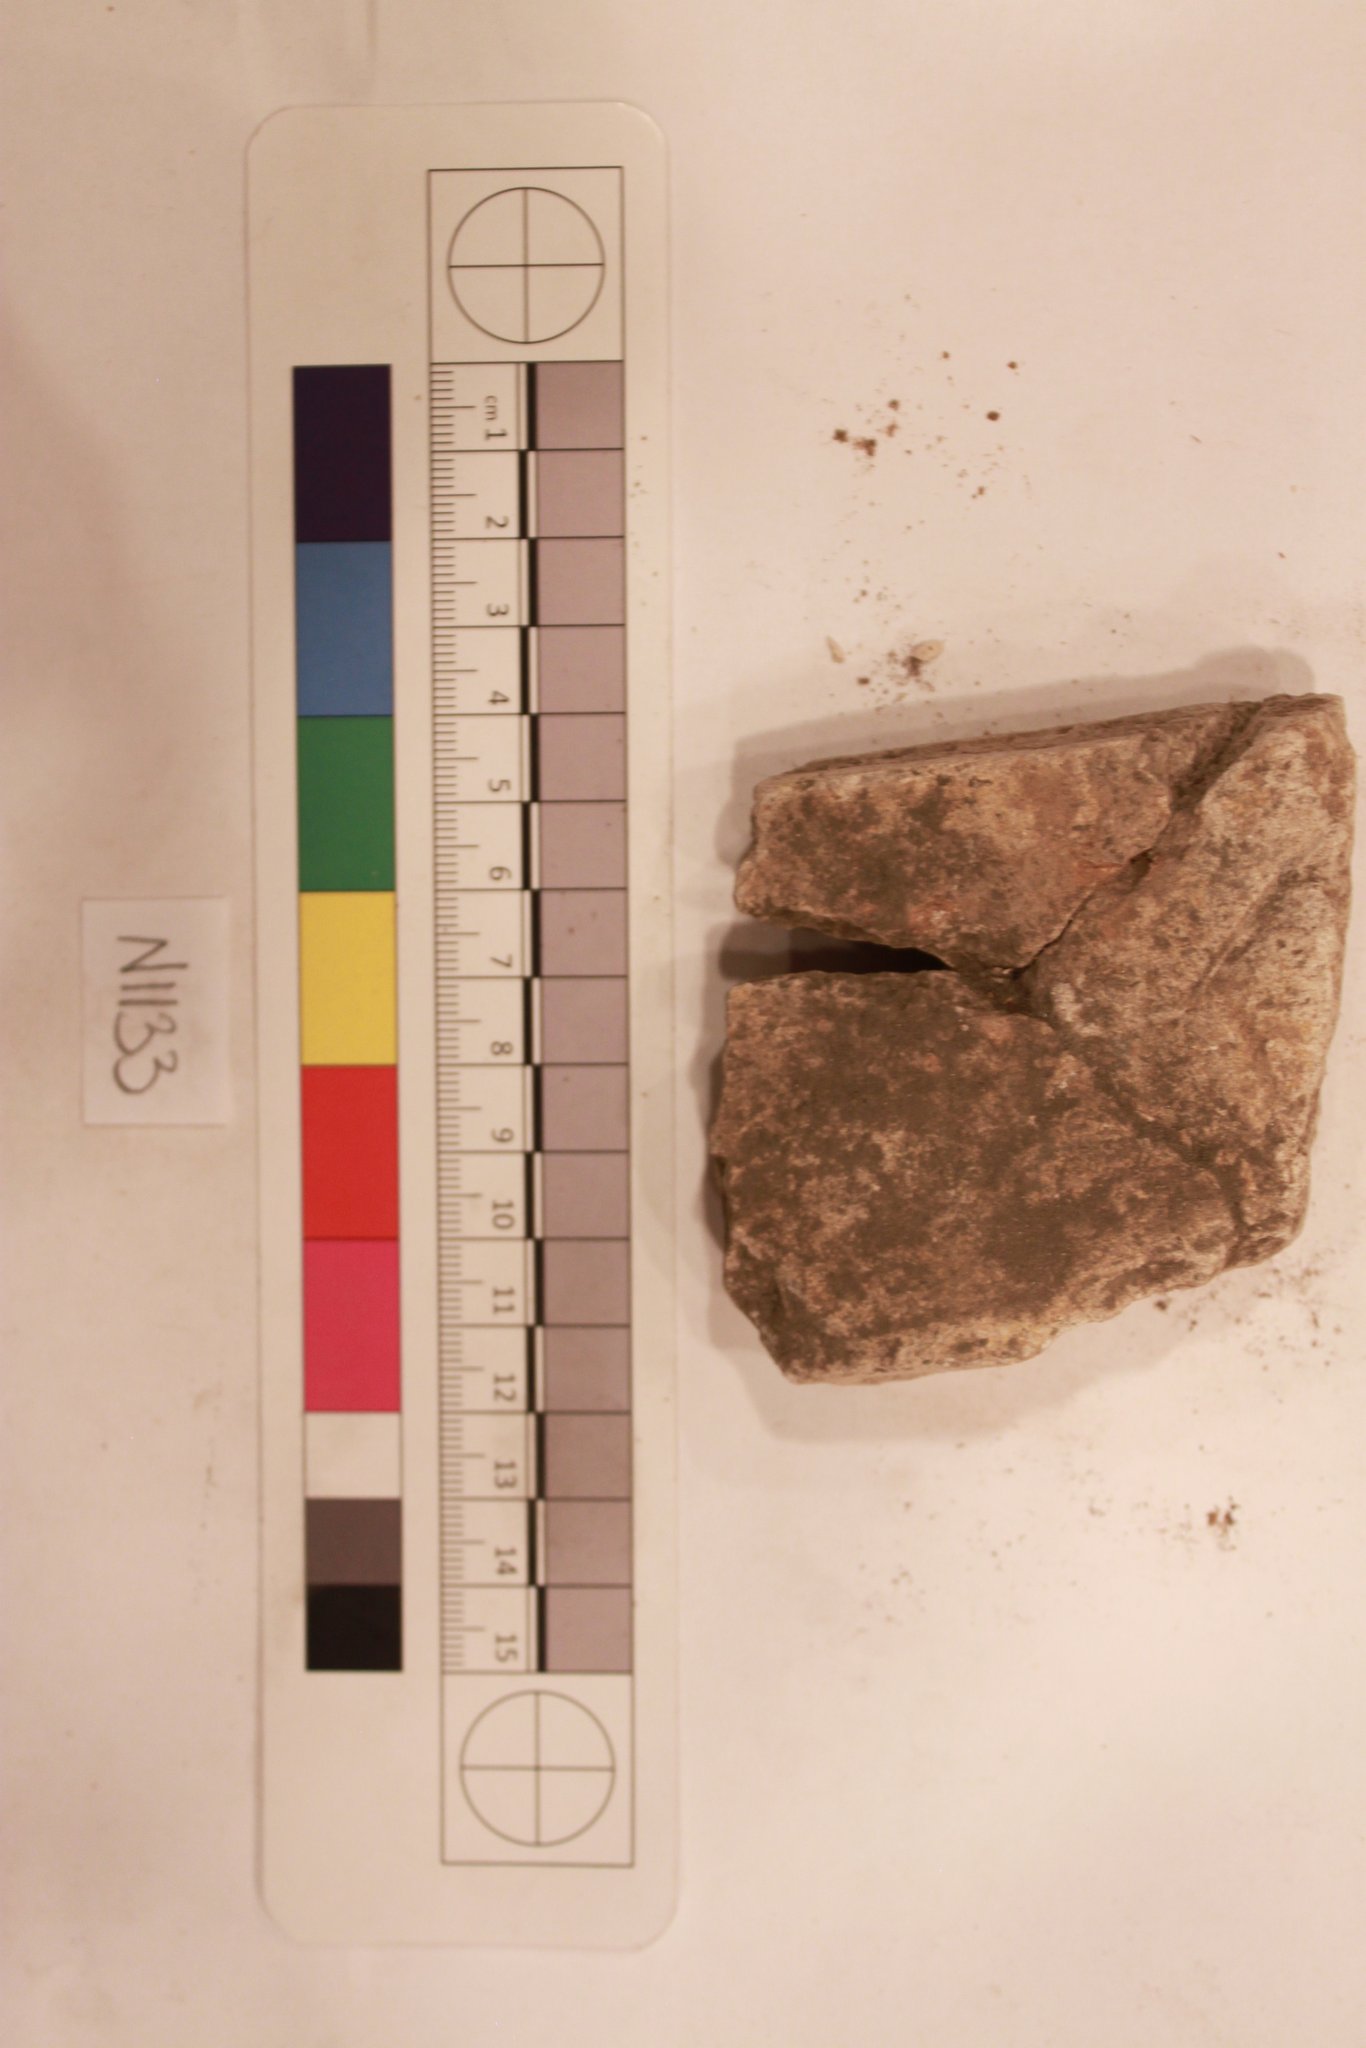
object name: fragment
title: Stucco Fragment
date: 701-1200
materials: plaster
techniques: carving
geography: iran